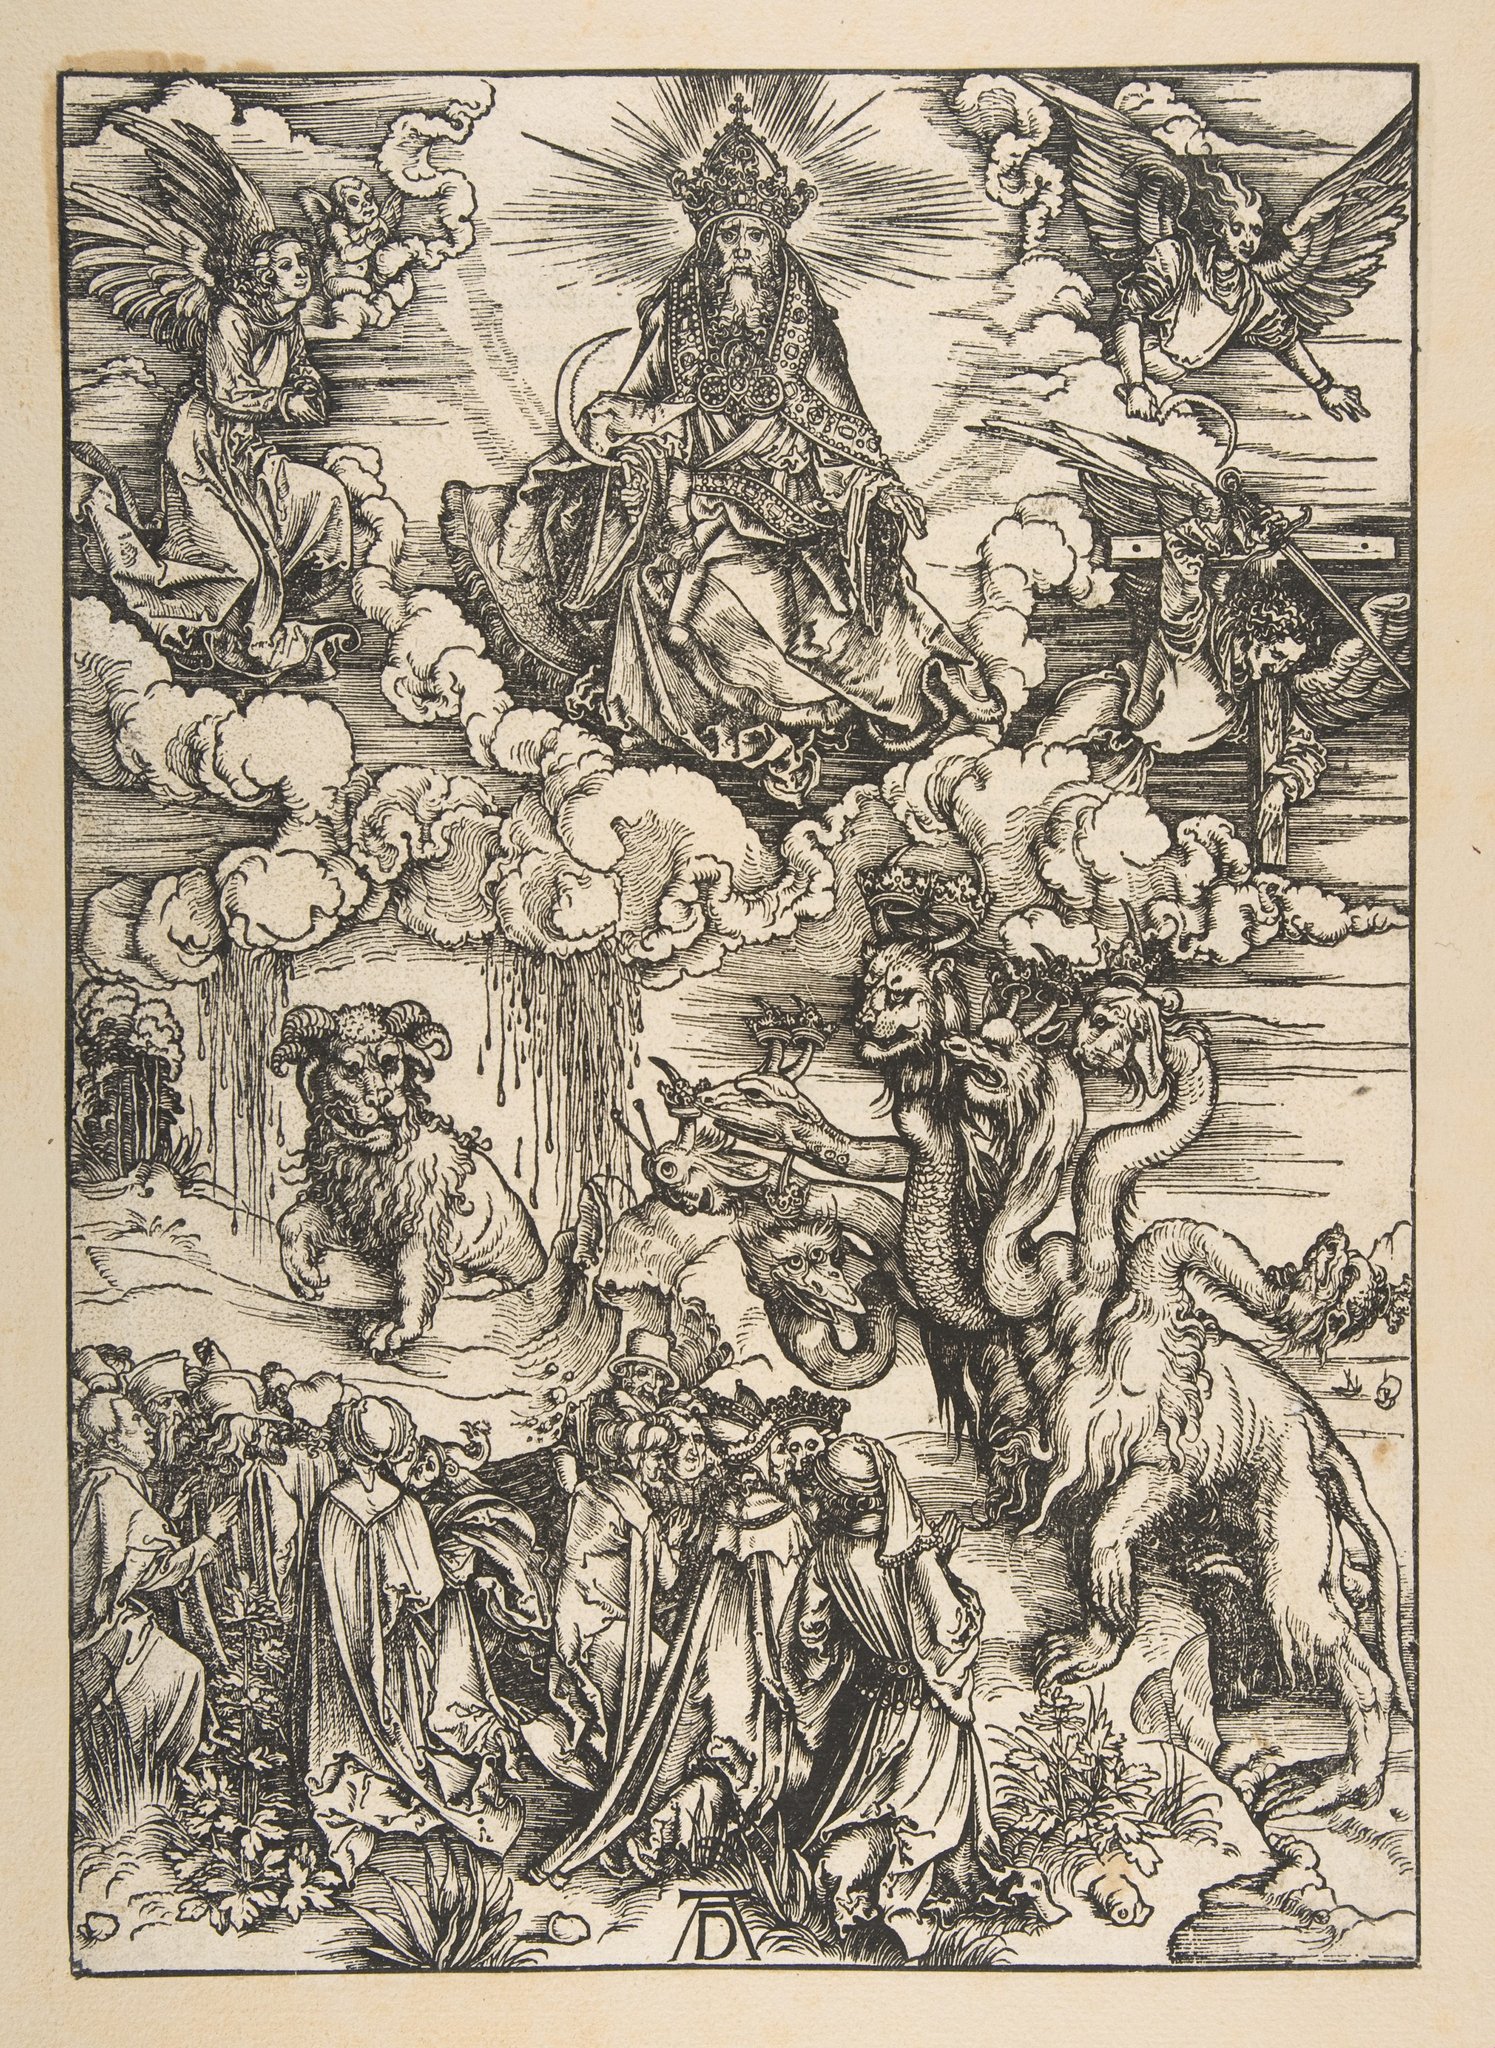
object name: print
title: The Beast with Two Horns Like a Lamb, from "The Apocalypse", Latin Edition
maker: albrecht dürer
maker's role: artist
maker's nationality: german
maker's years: 1471-1528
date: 1511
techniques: woodcut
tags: men,apocalypse